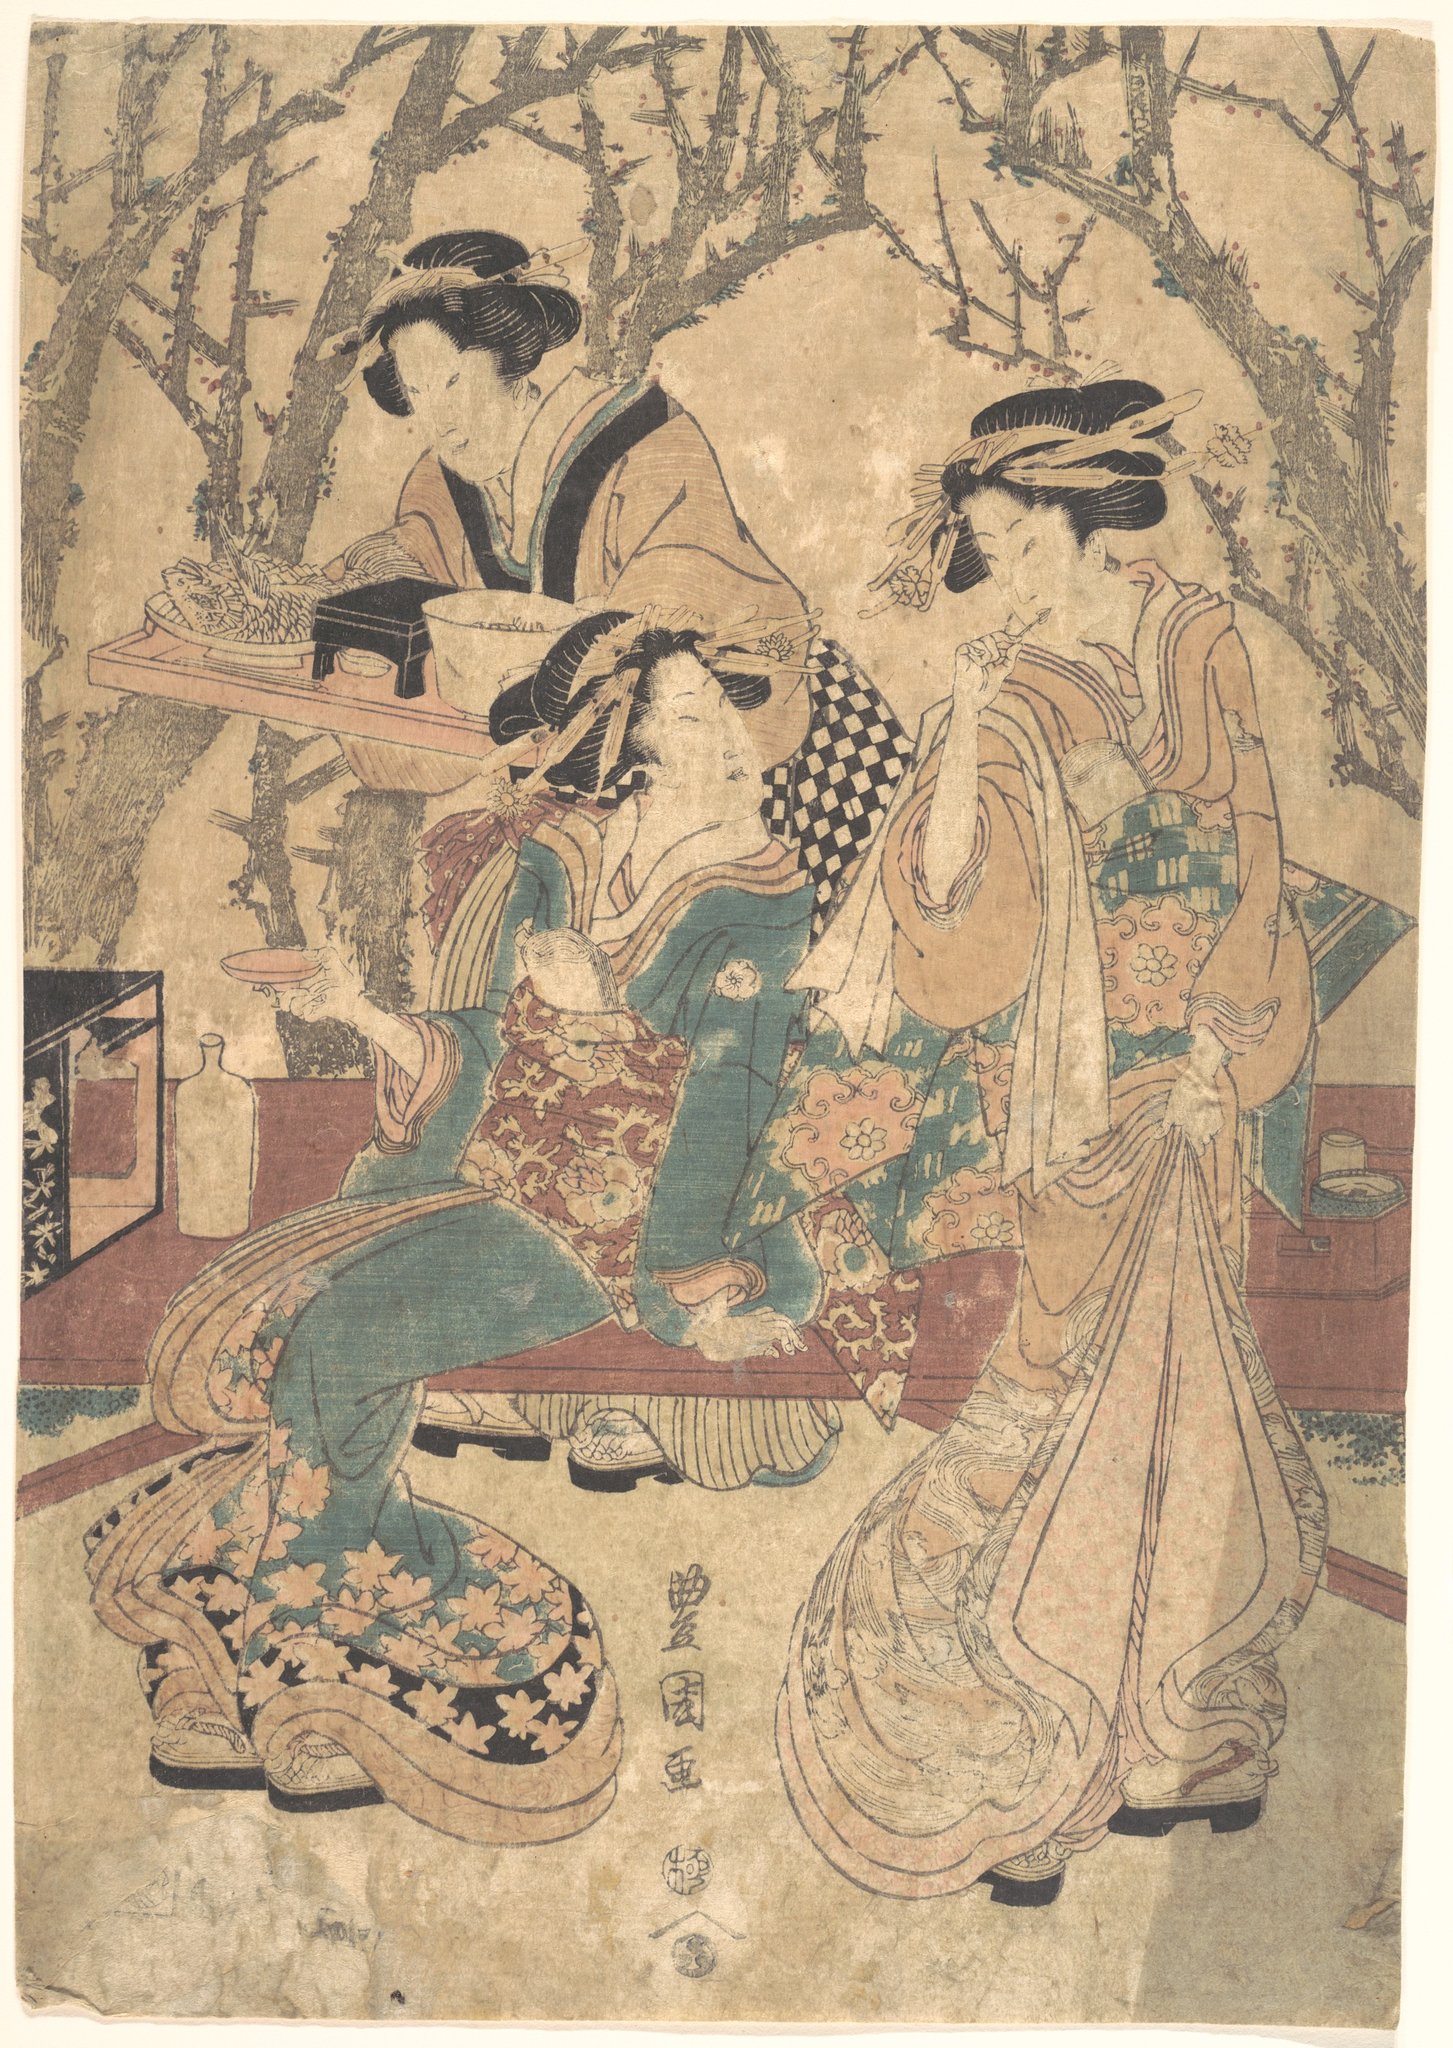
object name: woodblock print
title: Three Women Dining Before a Group of Trees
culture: japanese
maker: utagawa toyokuni i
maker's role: artist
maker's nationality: japanese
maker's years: 1769-1825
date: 1769-1825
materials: ink, paper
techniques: woodblock print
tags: women,trees,dining